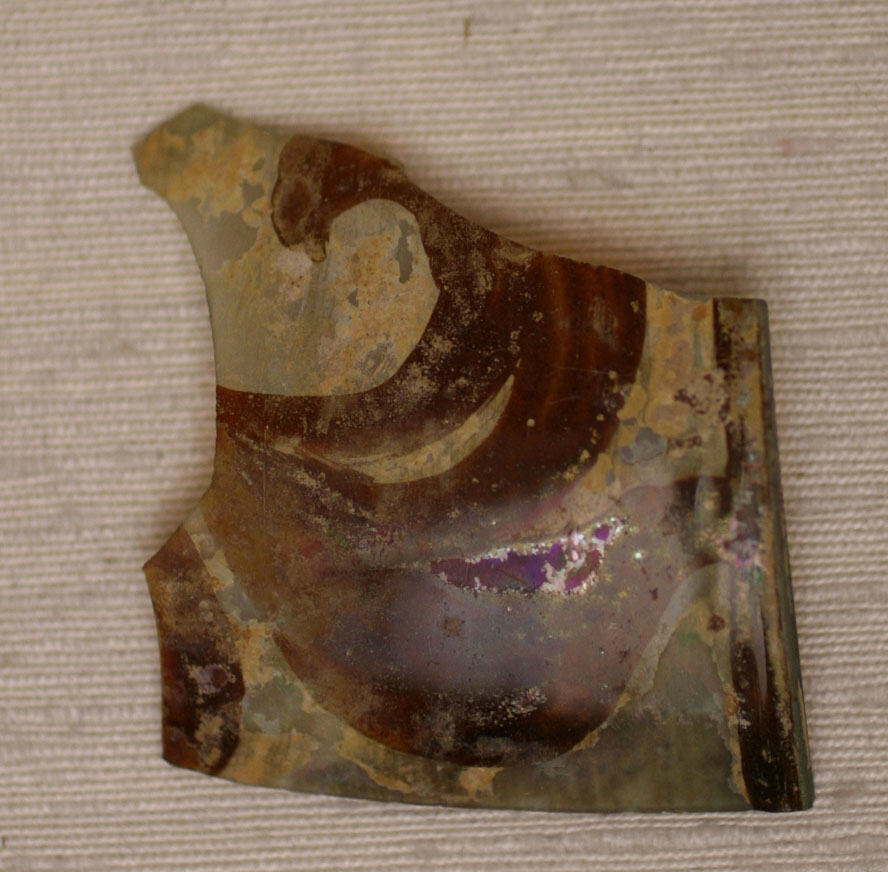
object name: fragment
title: Glass Fragment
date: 801-900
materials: glass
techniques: luster painting, stain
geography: egypt or iraq